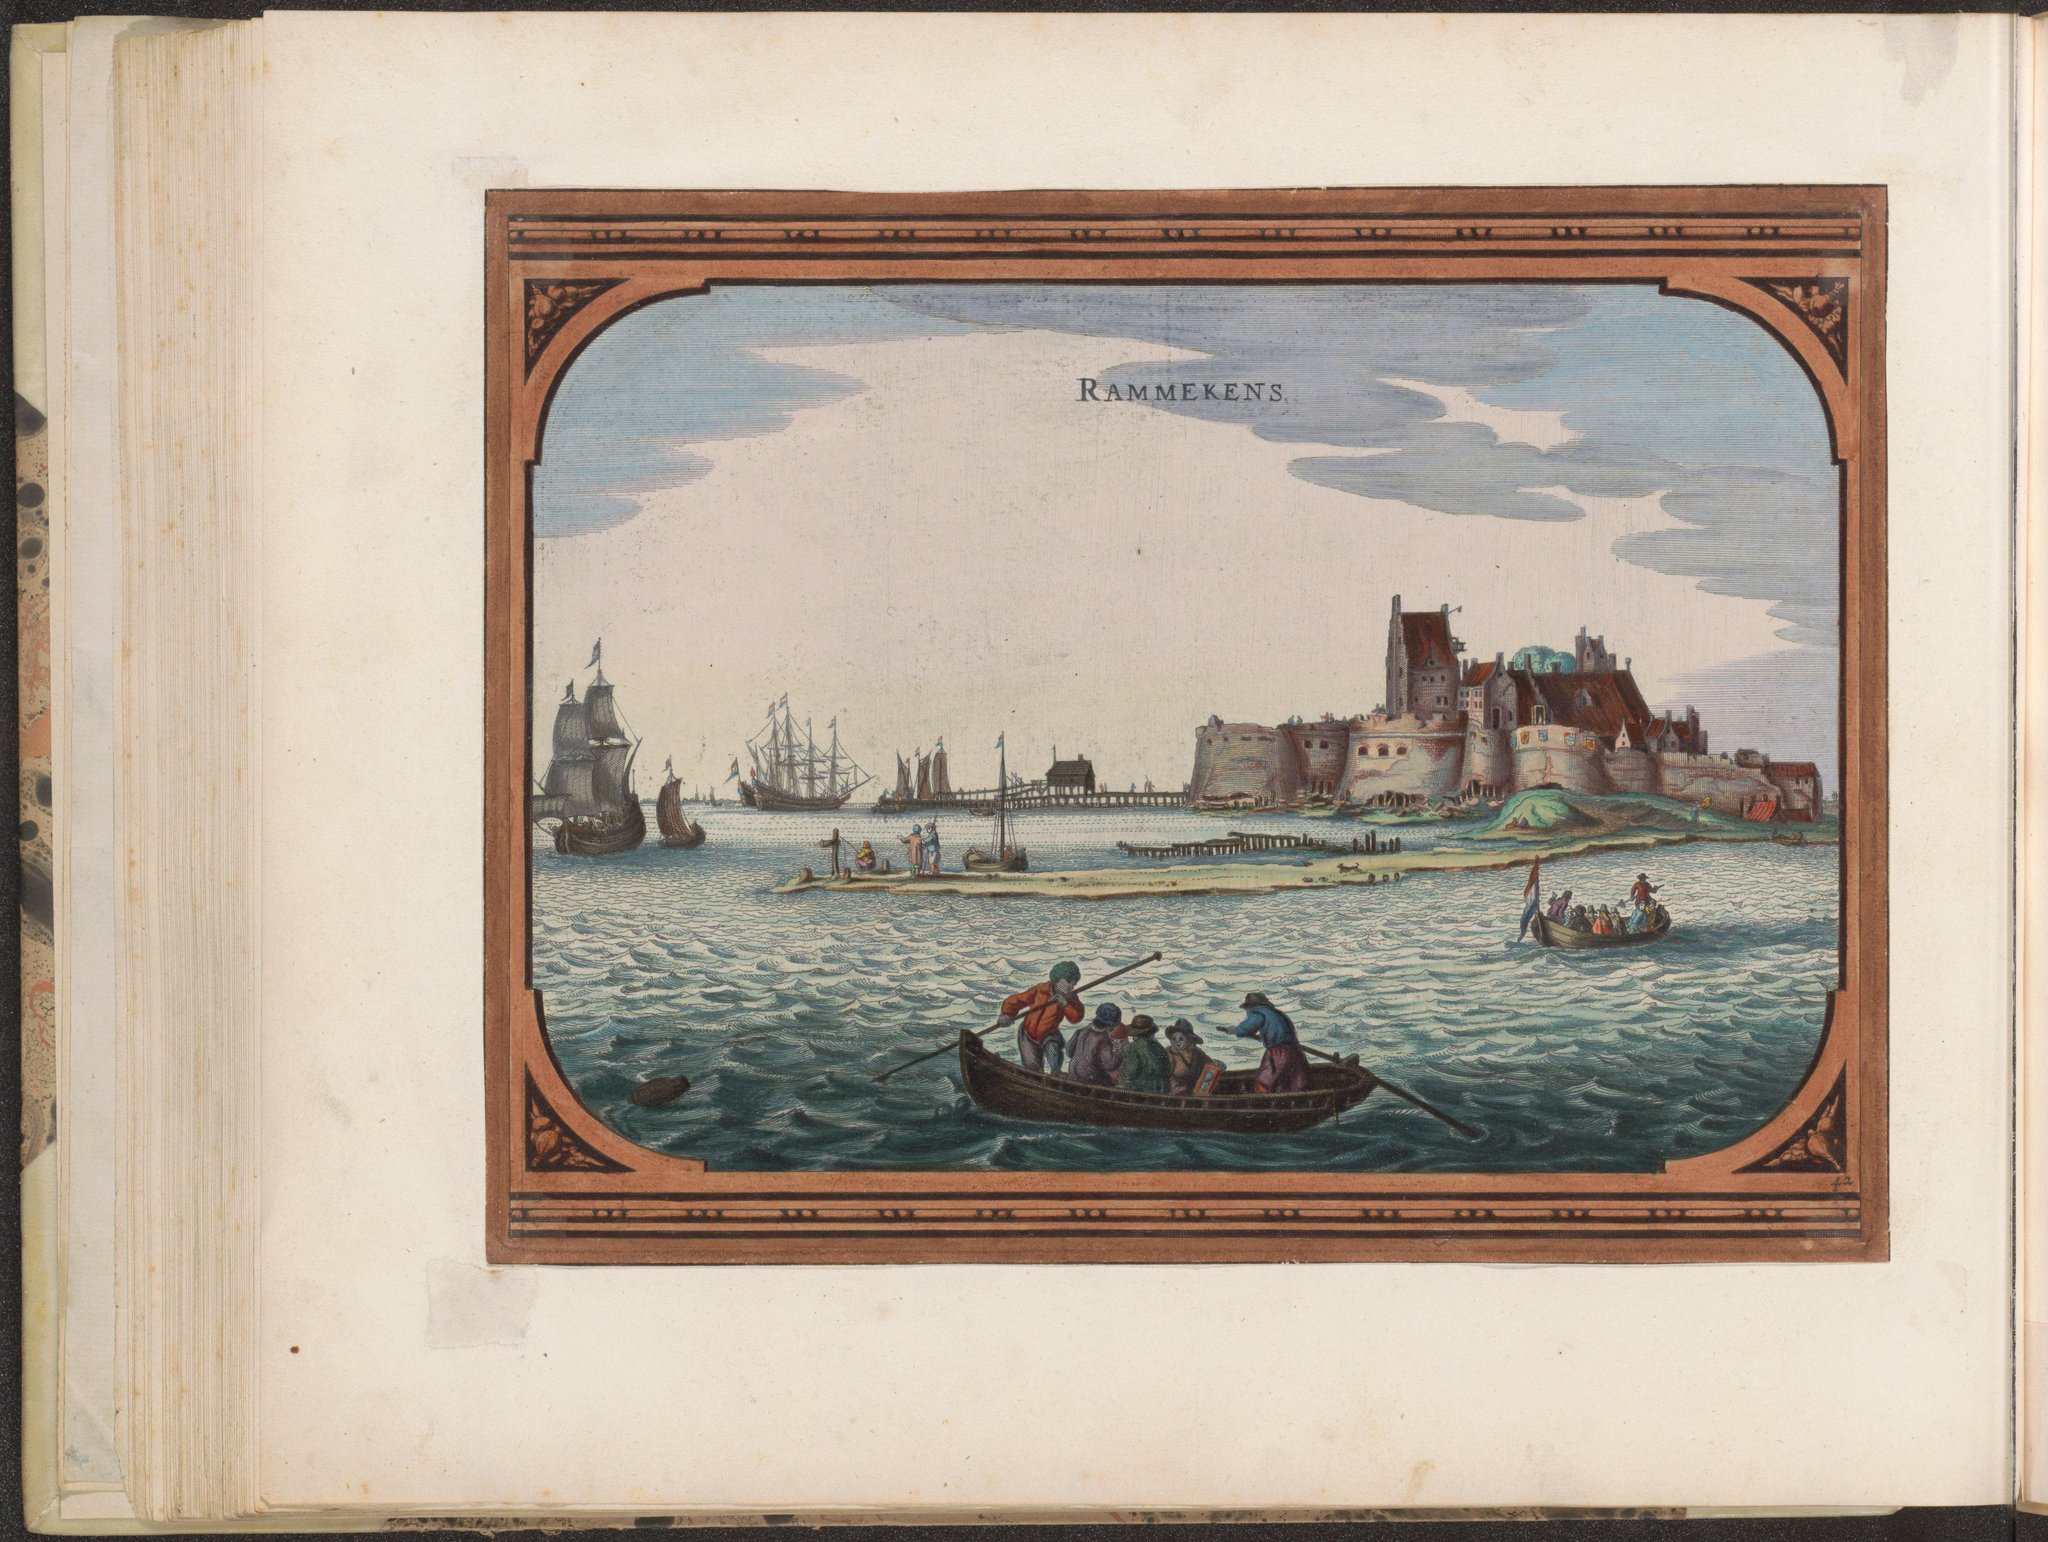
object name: print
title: Gezicht op Fort Rammekens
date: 1662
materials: paper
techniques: etching, hand coloring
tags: city-view, and landscape with man-made constructions, fortifications, military engineering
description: Gezicht op Fort Rammekens in Zeeland. Op de voorgrond twee boten. In de rechter zit een groep welgestelde heren. De schipper wijst de mannen op het fort. Links liggen enkele schepen. De prent maakt deel uit van een album.